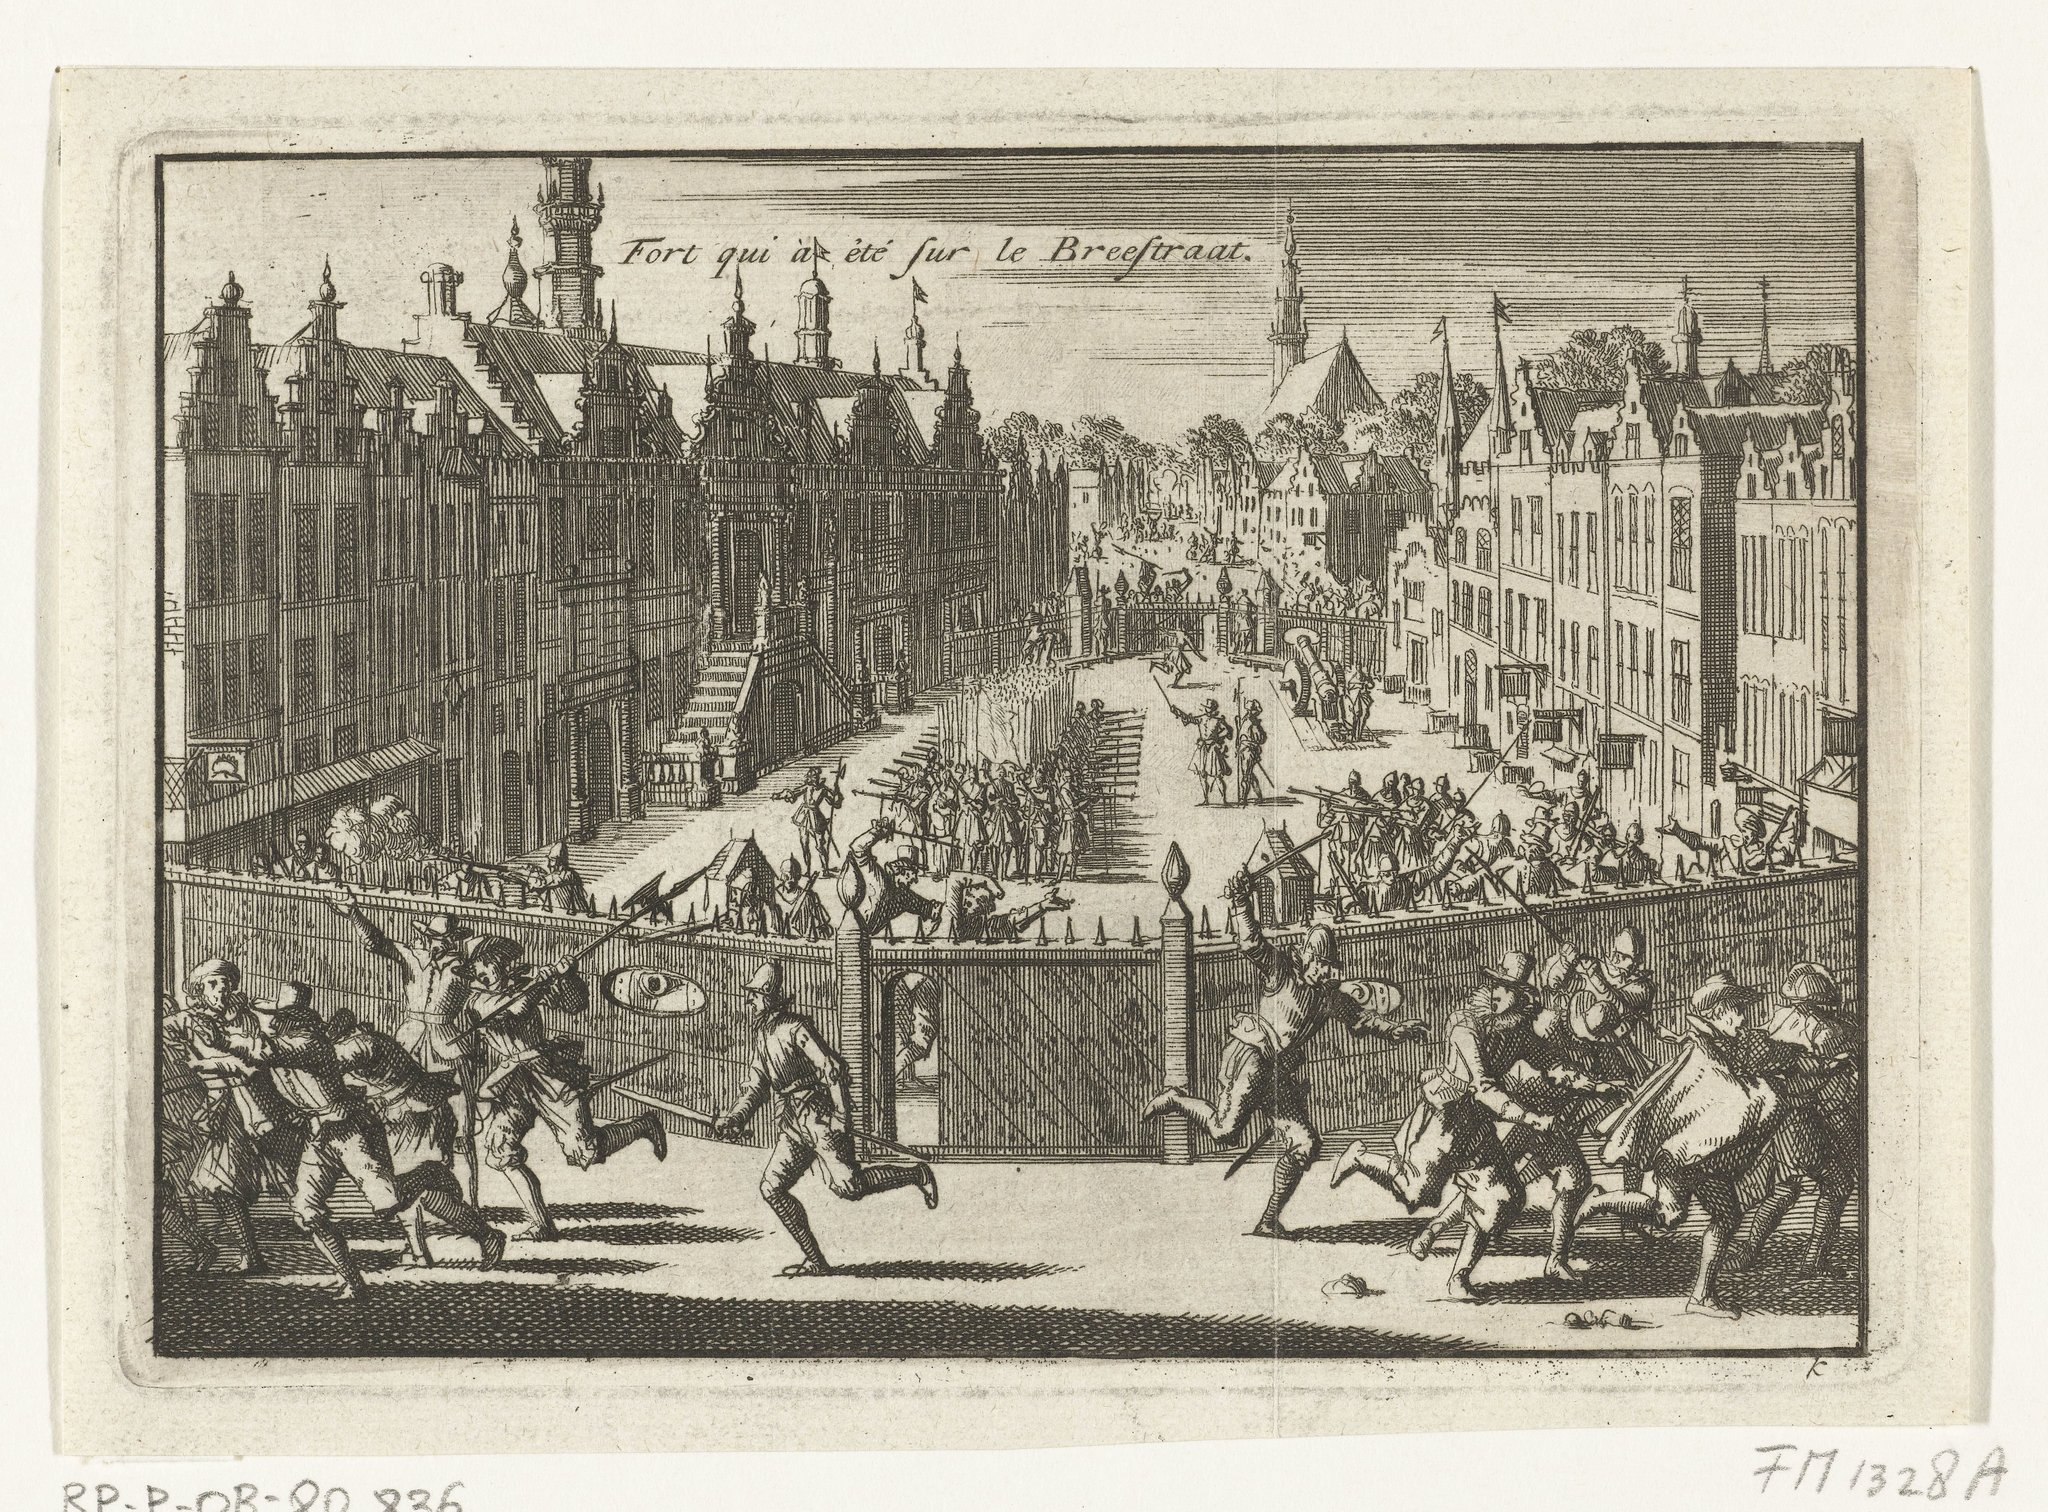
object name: history print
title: De arminiaanse schans in de Breestraat te Leiden, 1618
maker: jan luyken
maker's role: draughtsman, print maker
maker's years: 1649-1712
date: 1696-1700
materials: paper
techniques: etching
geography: northern netherlands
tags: breestraat, arminiaanse schans te leiden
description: De arminiaanse schans opgesteld in de Breestraat te Leiden, 1617-1618, Het publiek wordt door soldaten weggejaagd.